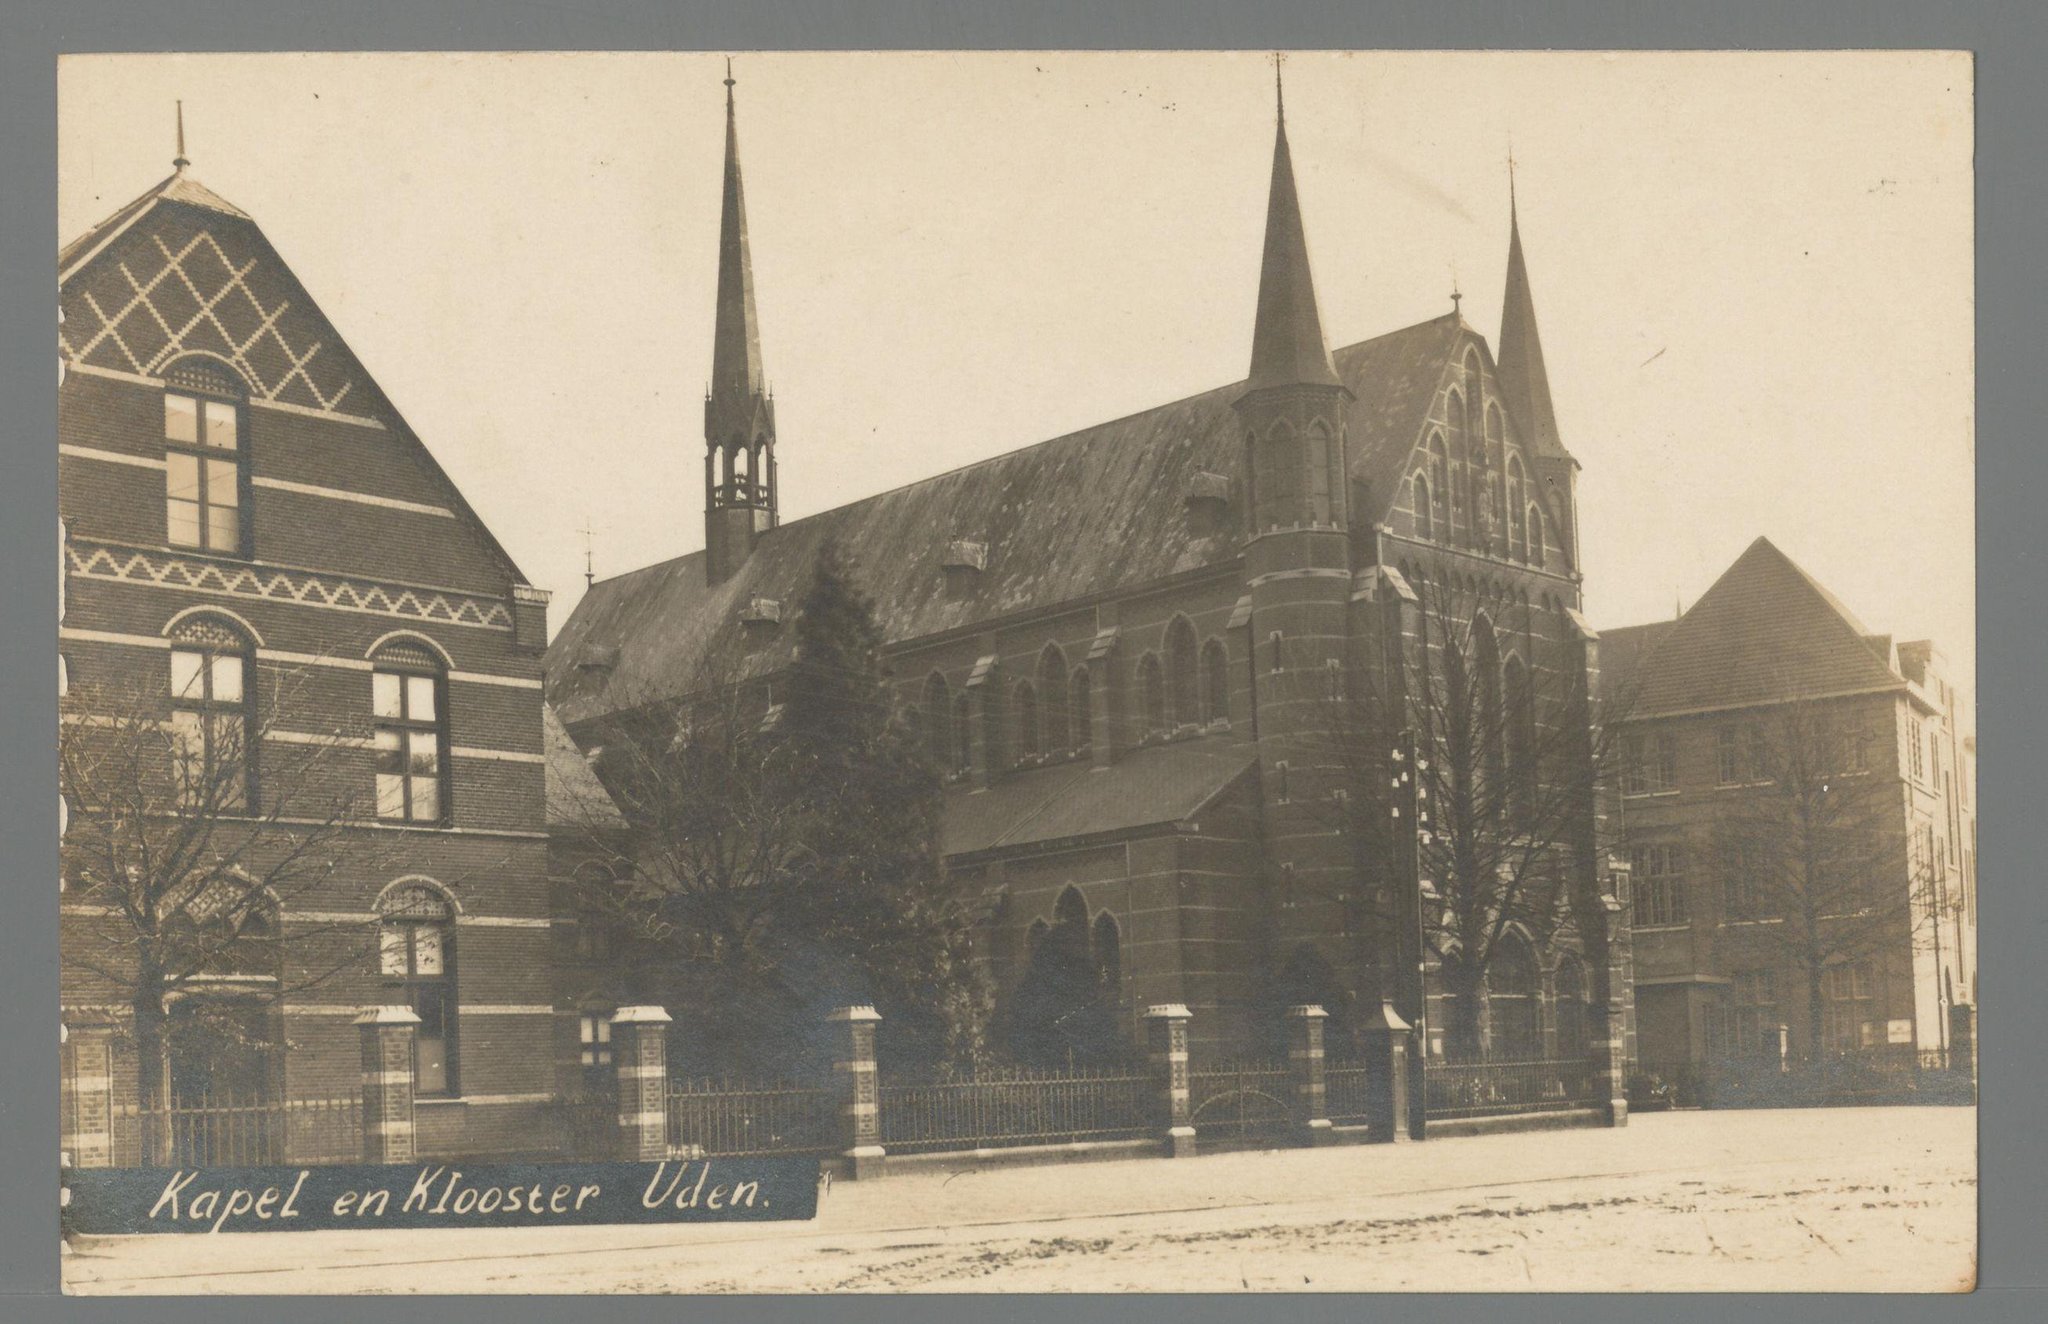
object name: photograph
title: Kapel en klooster Uden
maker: a. scheepens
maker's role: fotograaf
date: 1900-1930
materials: paper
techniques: gelatin silver print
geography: uden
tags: parts of church exterior and annexes: chapel - qq - small church, chapel, abbey, monastery, convent ~ roman catholic church